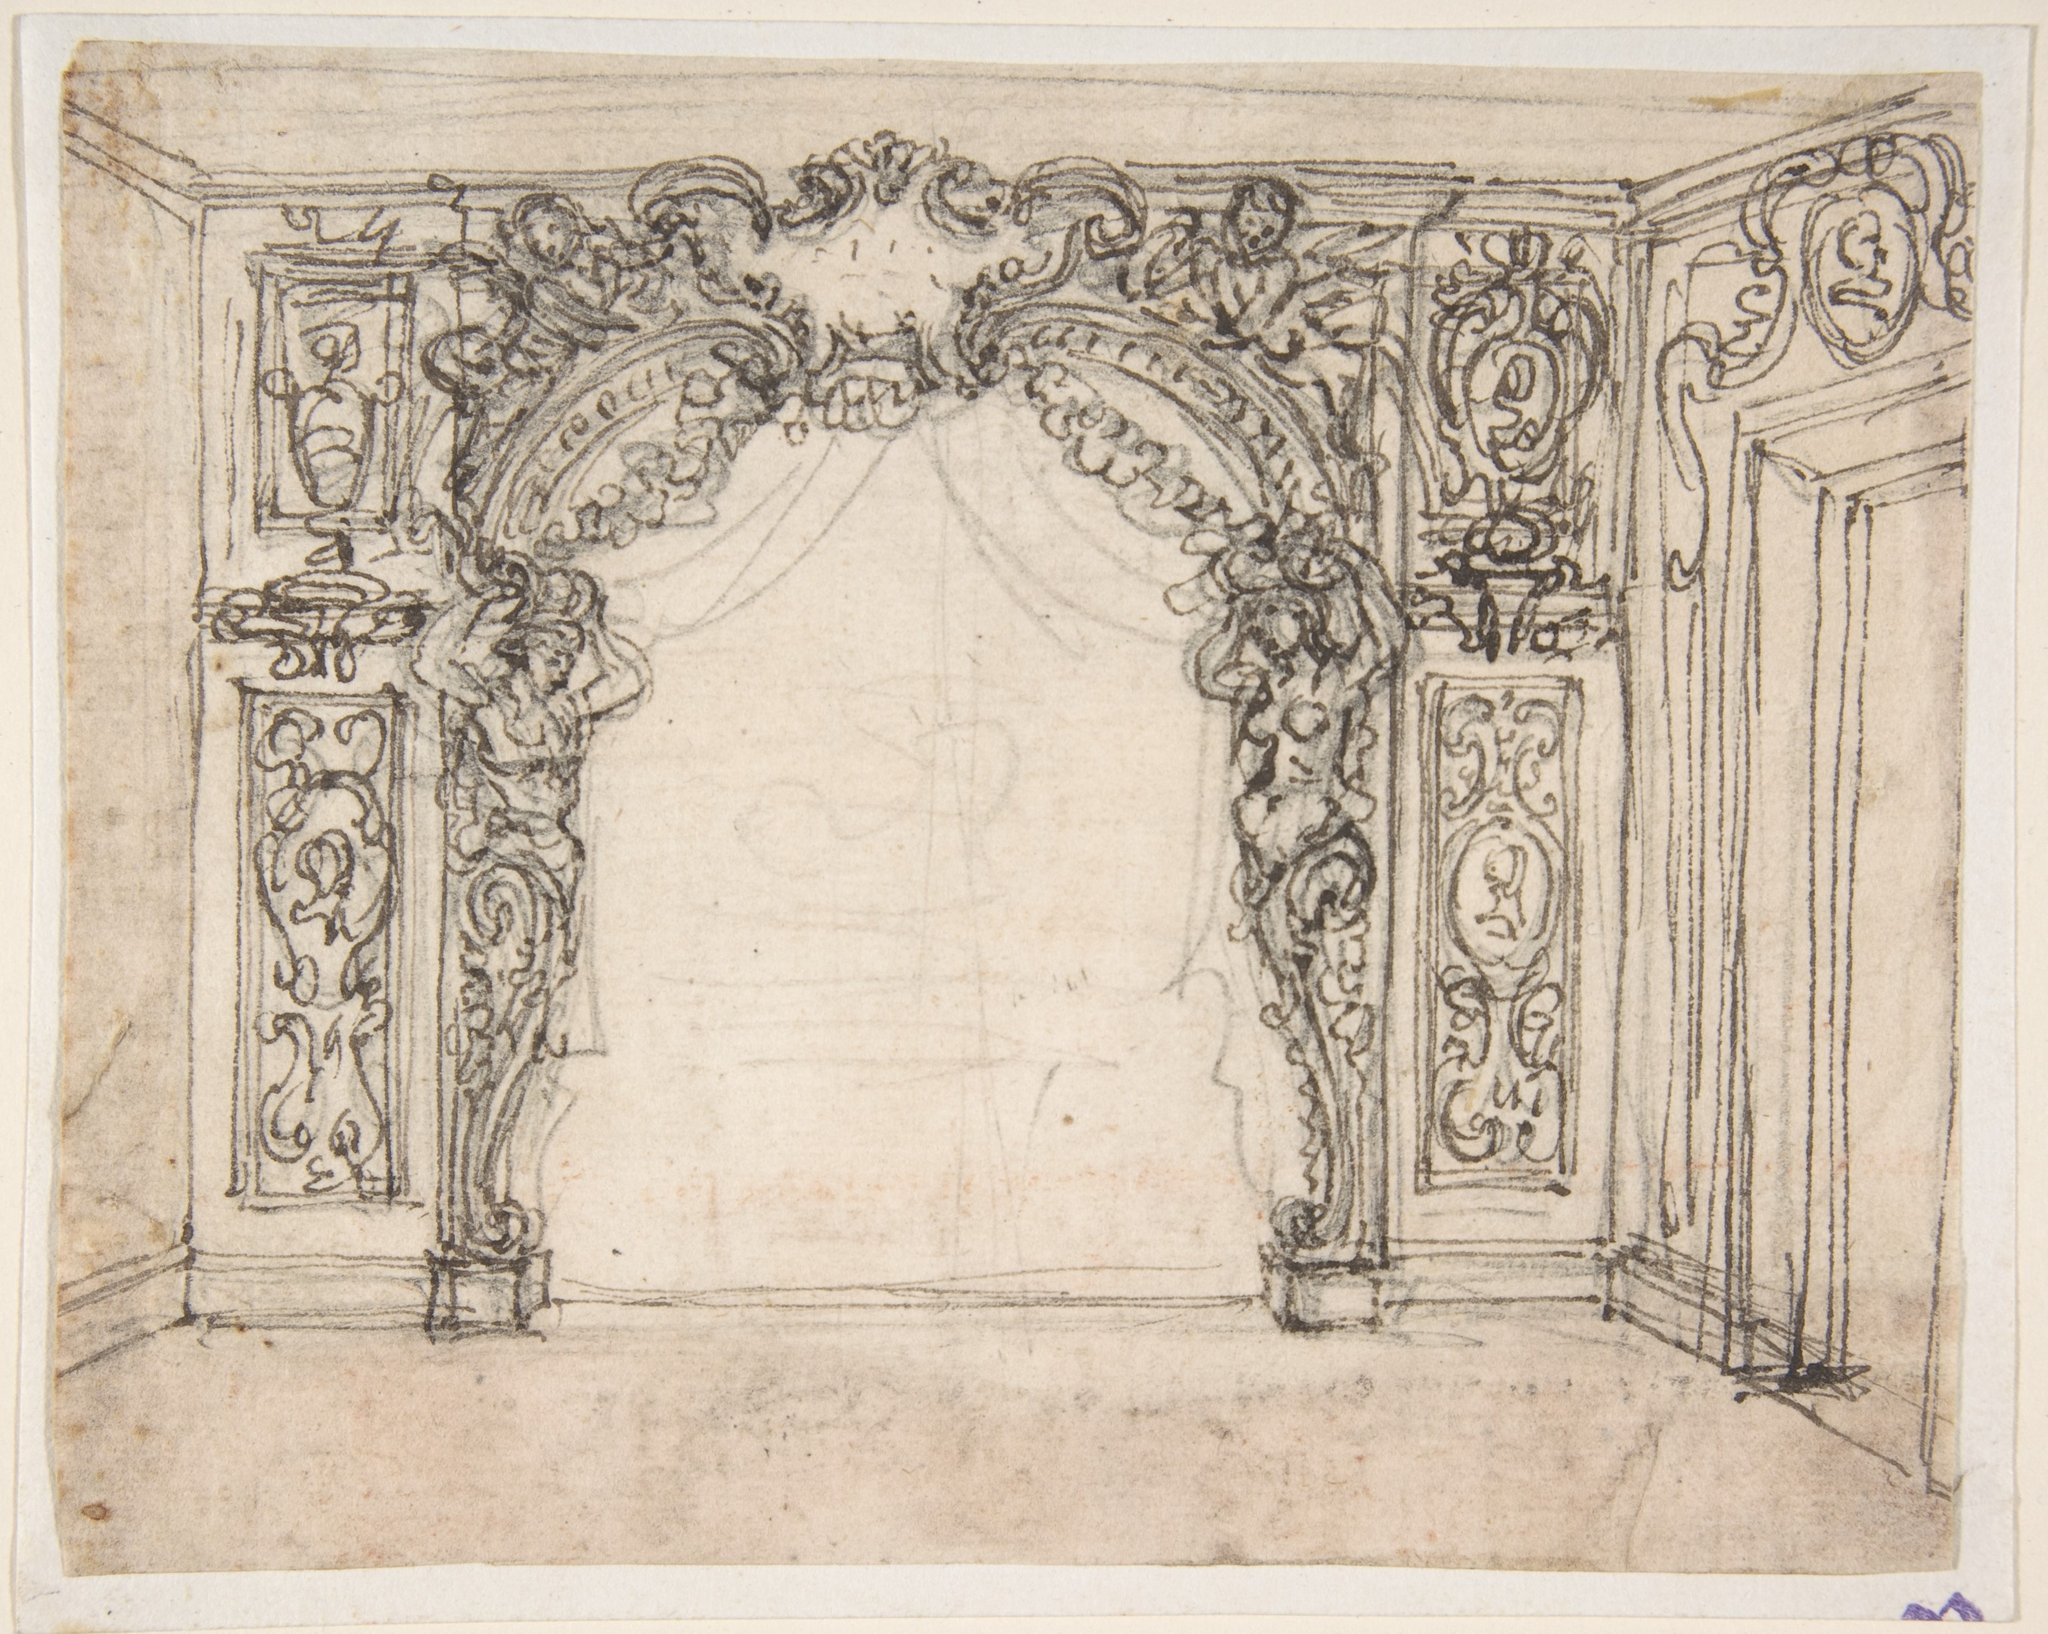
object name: drawing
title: Design for a Proscenium or Alcove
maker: giovanni battista foggini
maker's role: artist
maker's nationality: italian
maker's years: 1652-1725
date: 1672-1725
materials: chalk, ink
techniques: pen